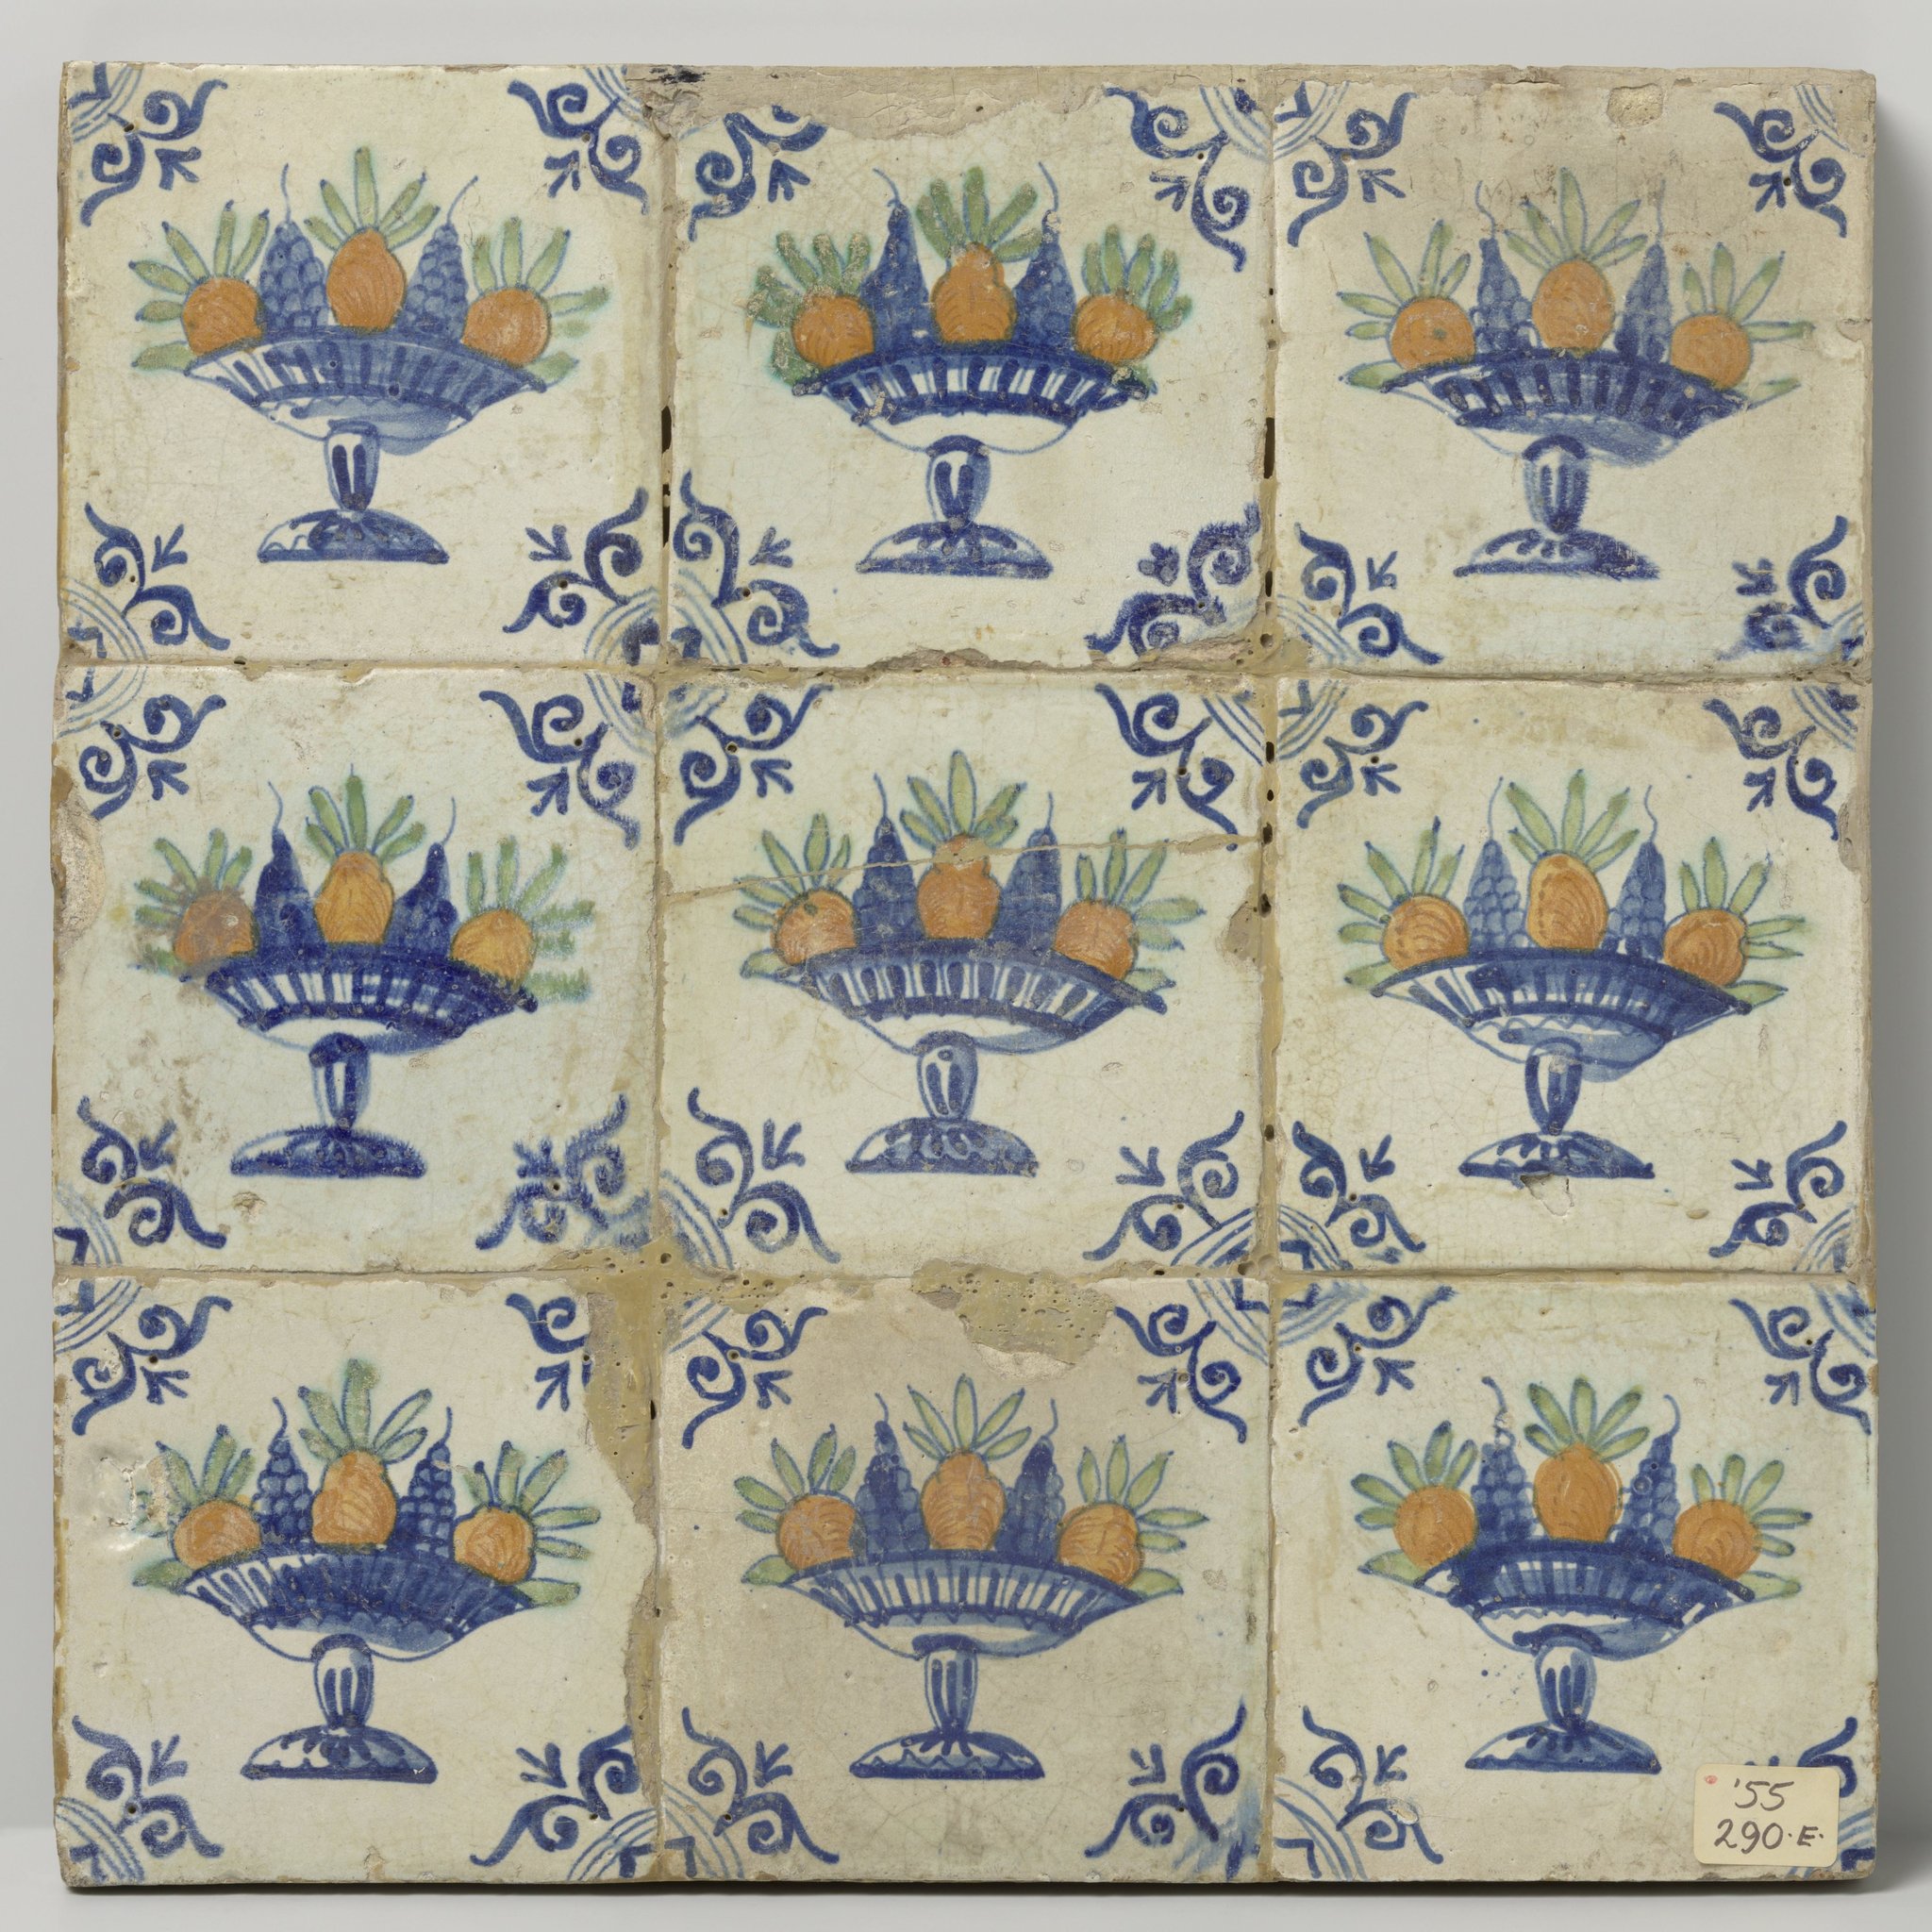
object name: tegelveld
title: Veld van negen tegels met fruitschalen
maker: Anonymous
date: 1620-1640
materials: earthenware, glaze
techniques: maiolica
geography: netherlands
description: Veld van negen tegels (3 x 3) elk met een veelkleurige (blauw, groen, geel en oranje) geschilderde fruitschaal. In de hoeken, een ossenkop.